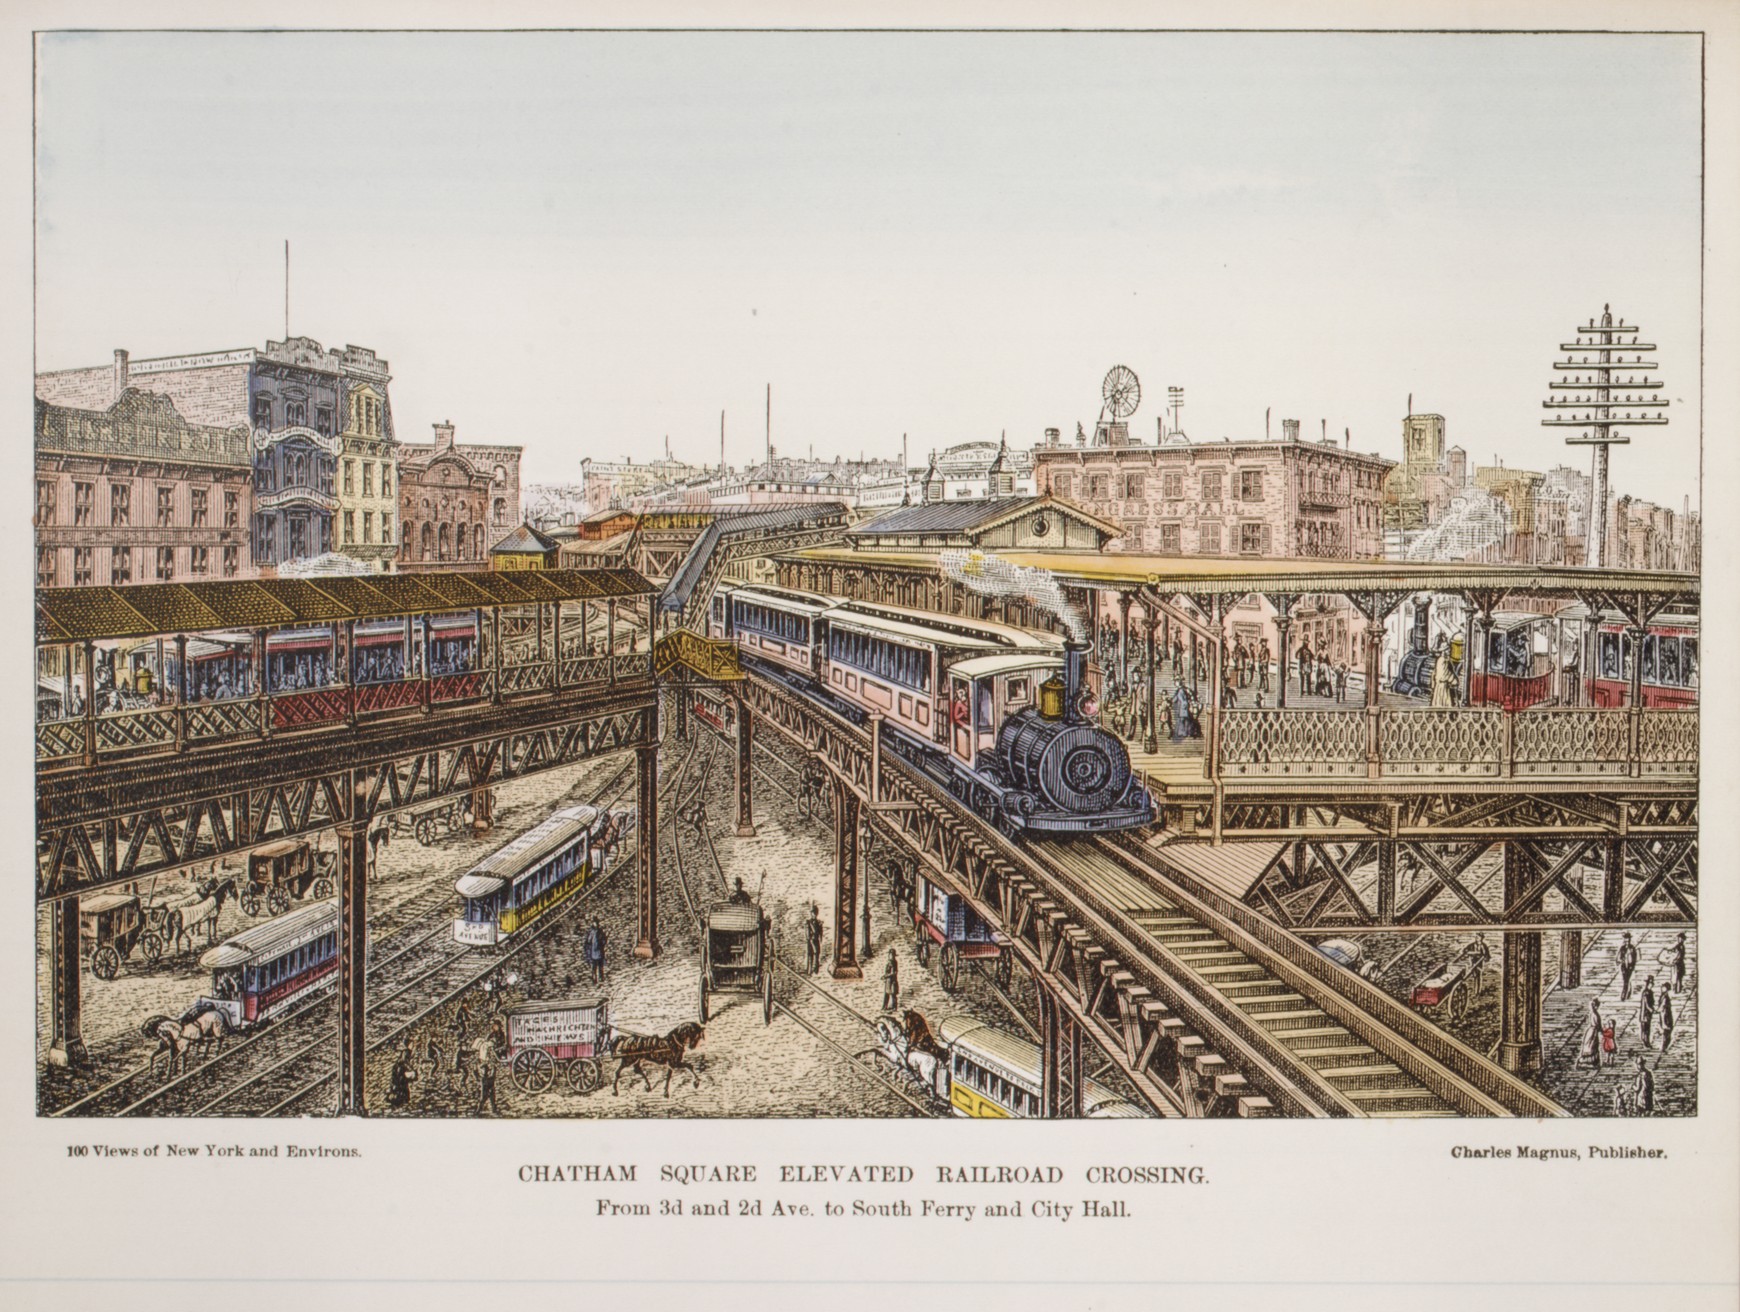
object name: print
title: Chatham Square Elevated Railroad Crossing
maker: charles magnus & company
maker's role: publisher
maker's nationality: american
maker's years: 1854-1880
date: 1850-1900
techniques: hand coloring, engraving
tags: cities,railways,horses,carriages,trains,new york city